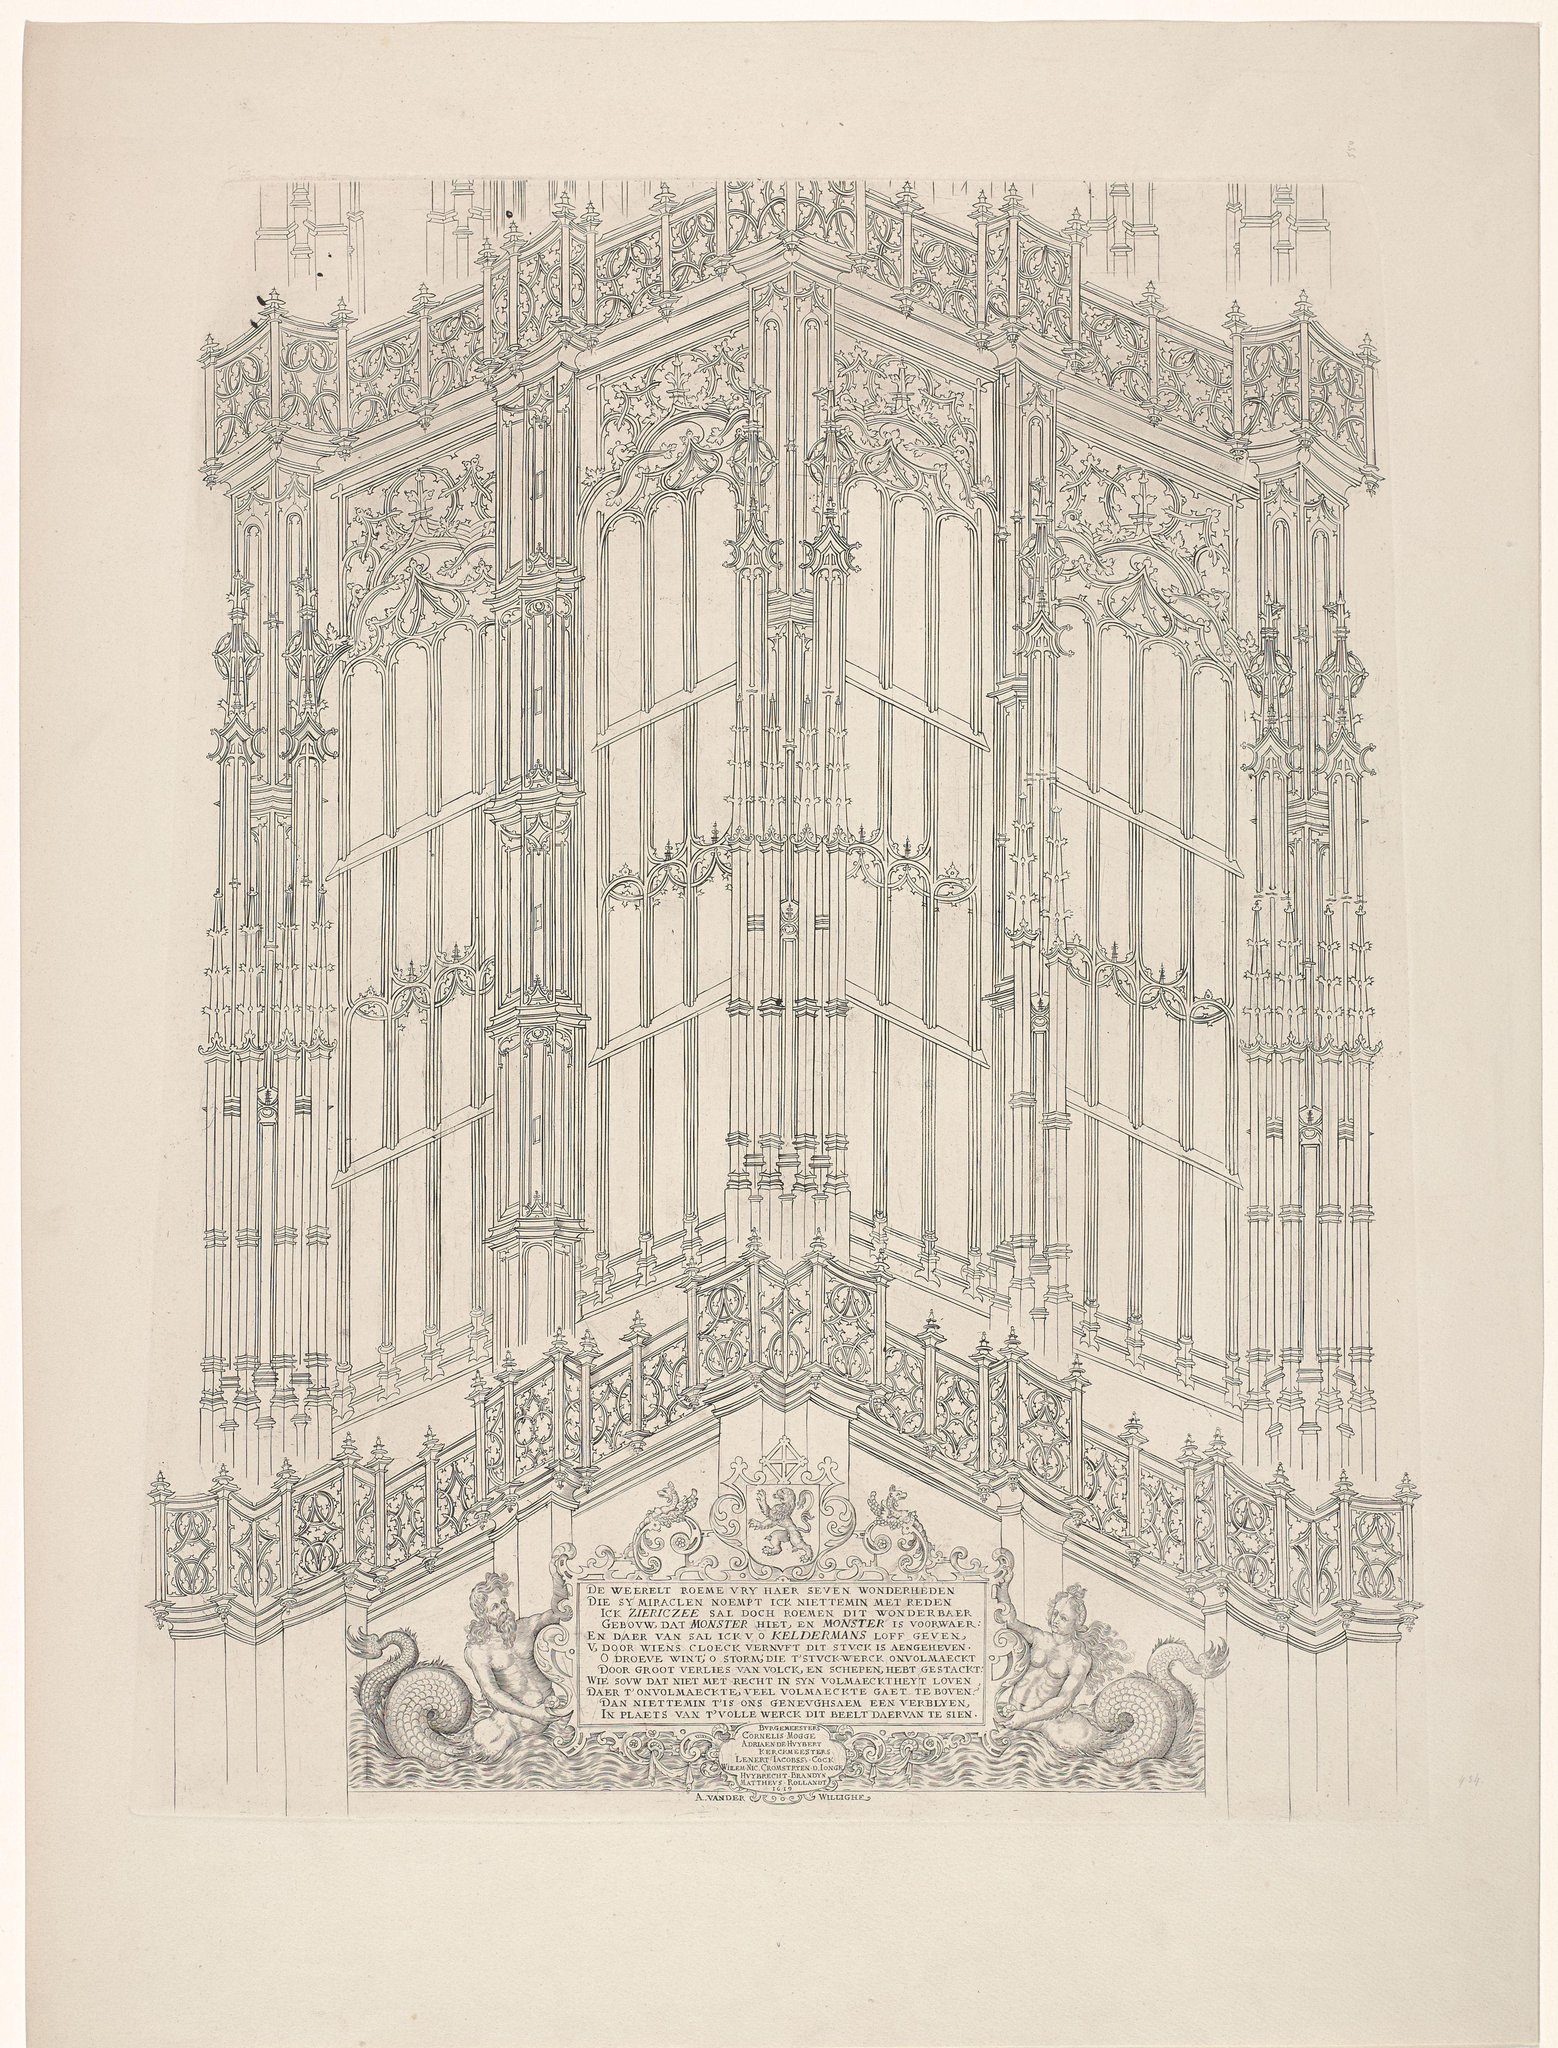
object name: print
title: Torenspits van de Sint Lievensmonsterkerk te Zierikzee, onder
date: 1619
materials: paper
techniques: engraving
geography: zierikzee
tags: parts of church exterior and annexes: tower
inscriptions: collector's mark: Lugt 2228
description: Ontwerp voor het onderste gedeelte van de Sint Lievensmonstertoren. Onderaan het wapenschild van Zierikzee en een twaalfregelig lofdicht in het Nederlands. In de cartouche eronder de namen van burgemeesters.